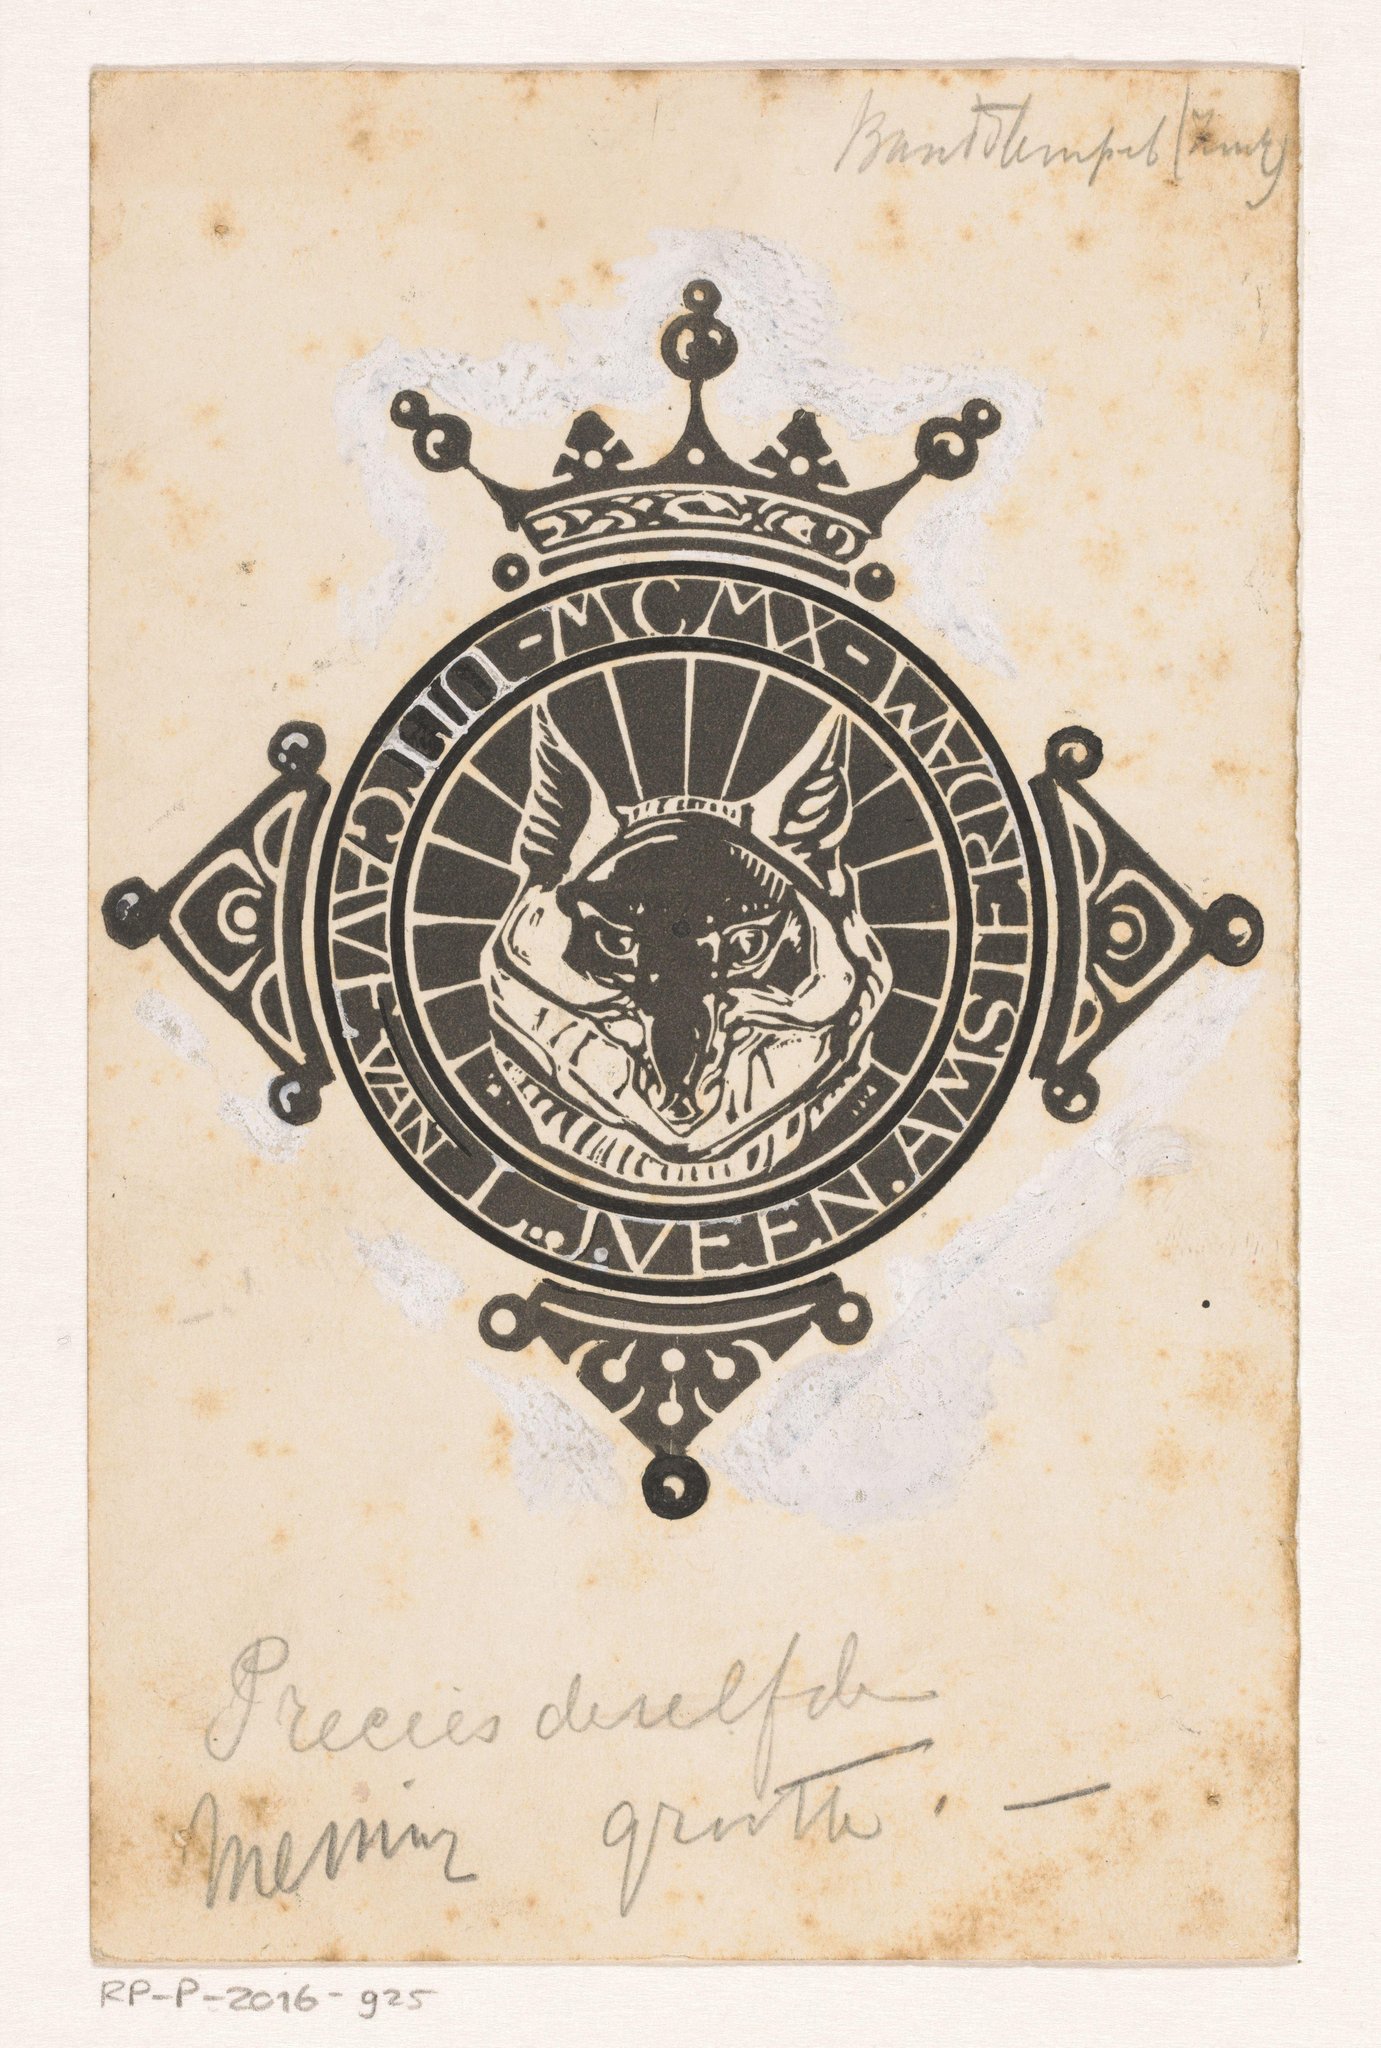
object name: study for binding design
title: Bandontwerp voor: Stijn Streuvels, Reinaert de Vos, 1910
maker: Anonymous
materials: paint, ink, paper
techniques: brush, lithograph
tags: fable of reynard the fox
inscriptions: :, annotation: ‘Bandstempel (Zink)’, collector's mark: Lugt 2228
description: Ontwerp voor een bandstempel met de kop van de vos Reinaert in een versierde cirkel met bovenaan een kroon.